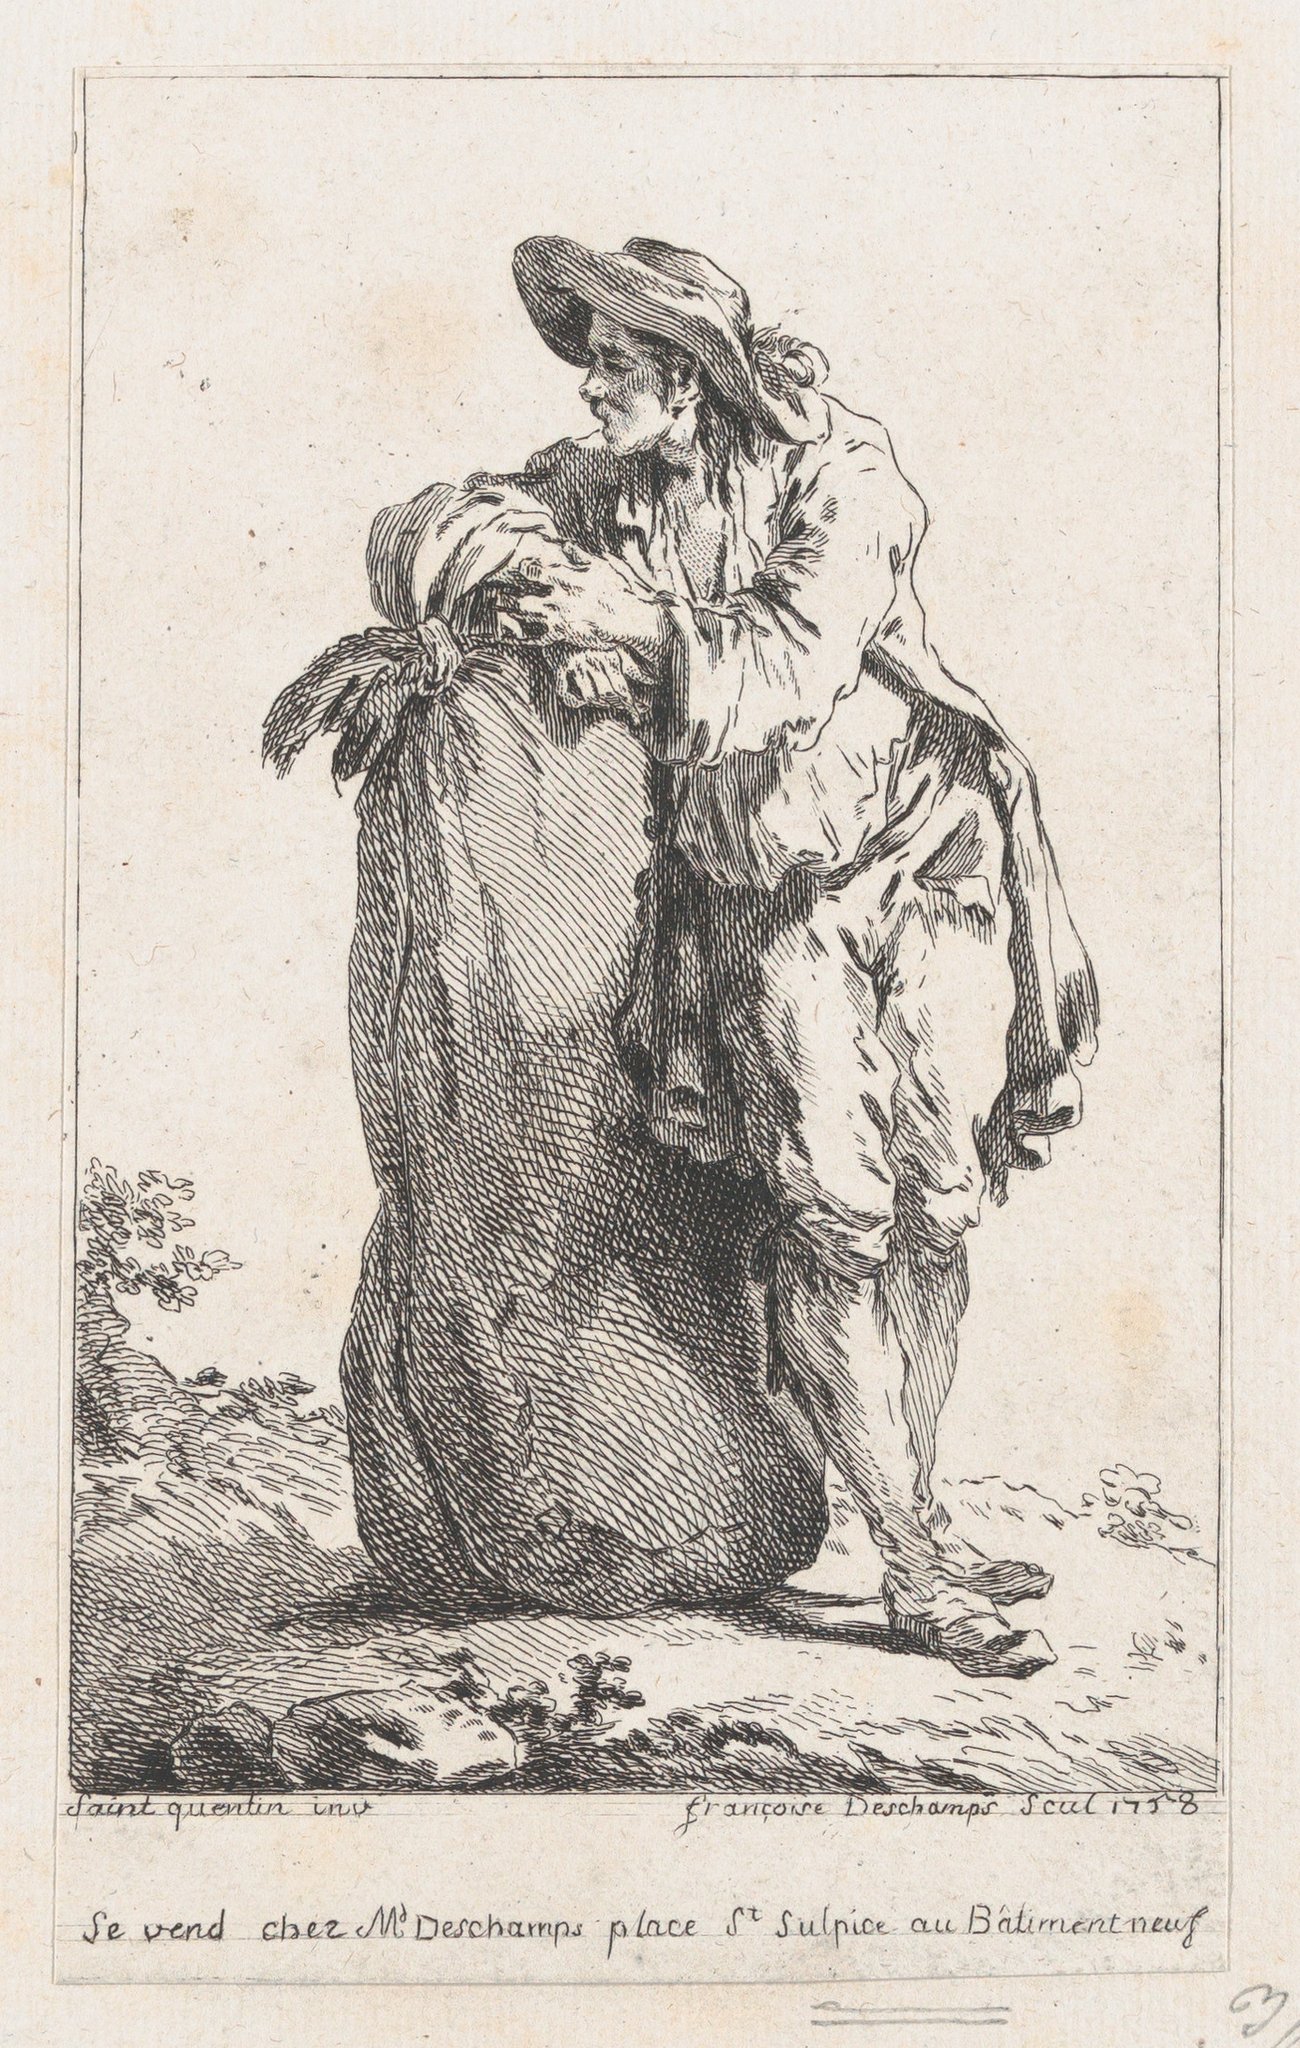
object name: print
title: Peasant Leaning on a Sack of Grain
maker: catherine-francoise beauvarlet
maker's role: artist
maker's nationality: french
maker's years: 1737-1769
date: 1758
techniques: etching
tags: men